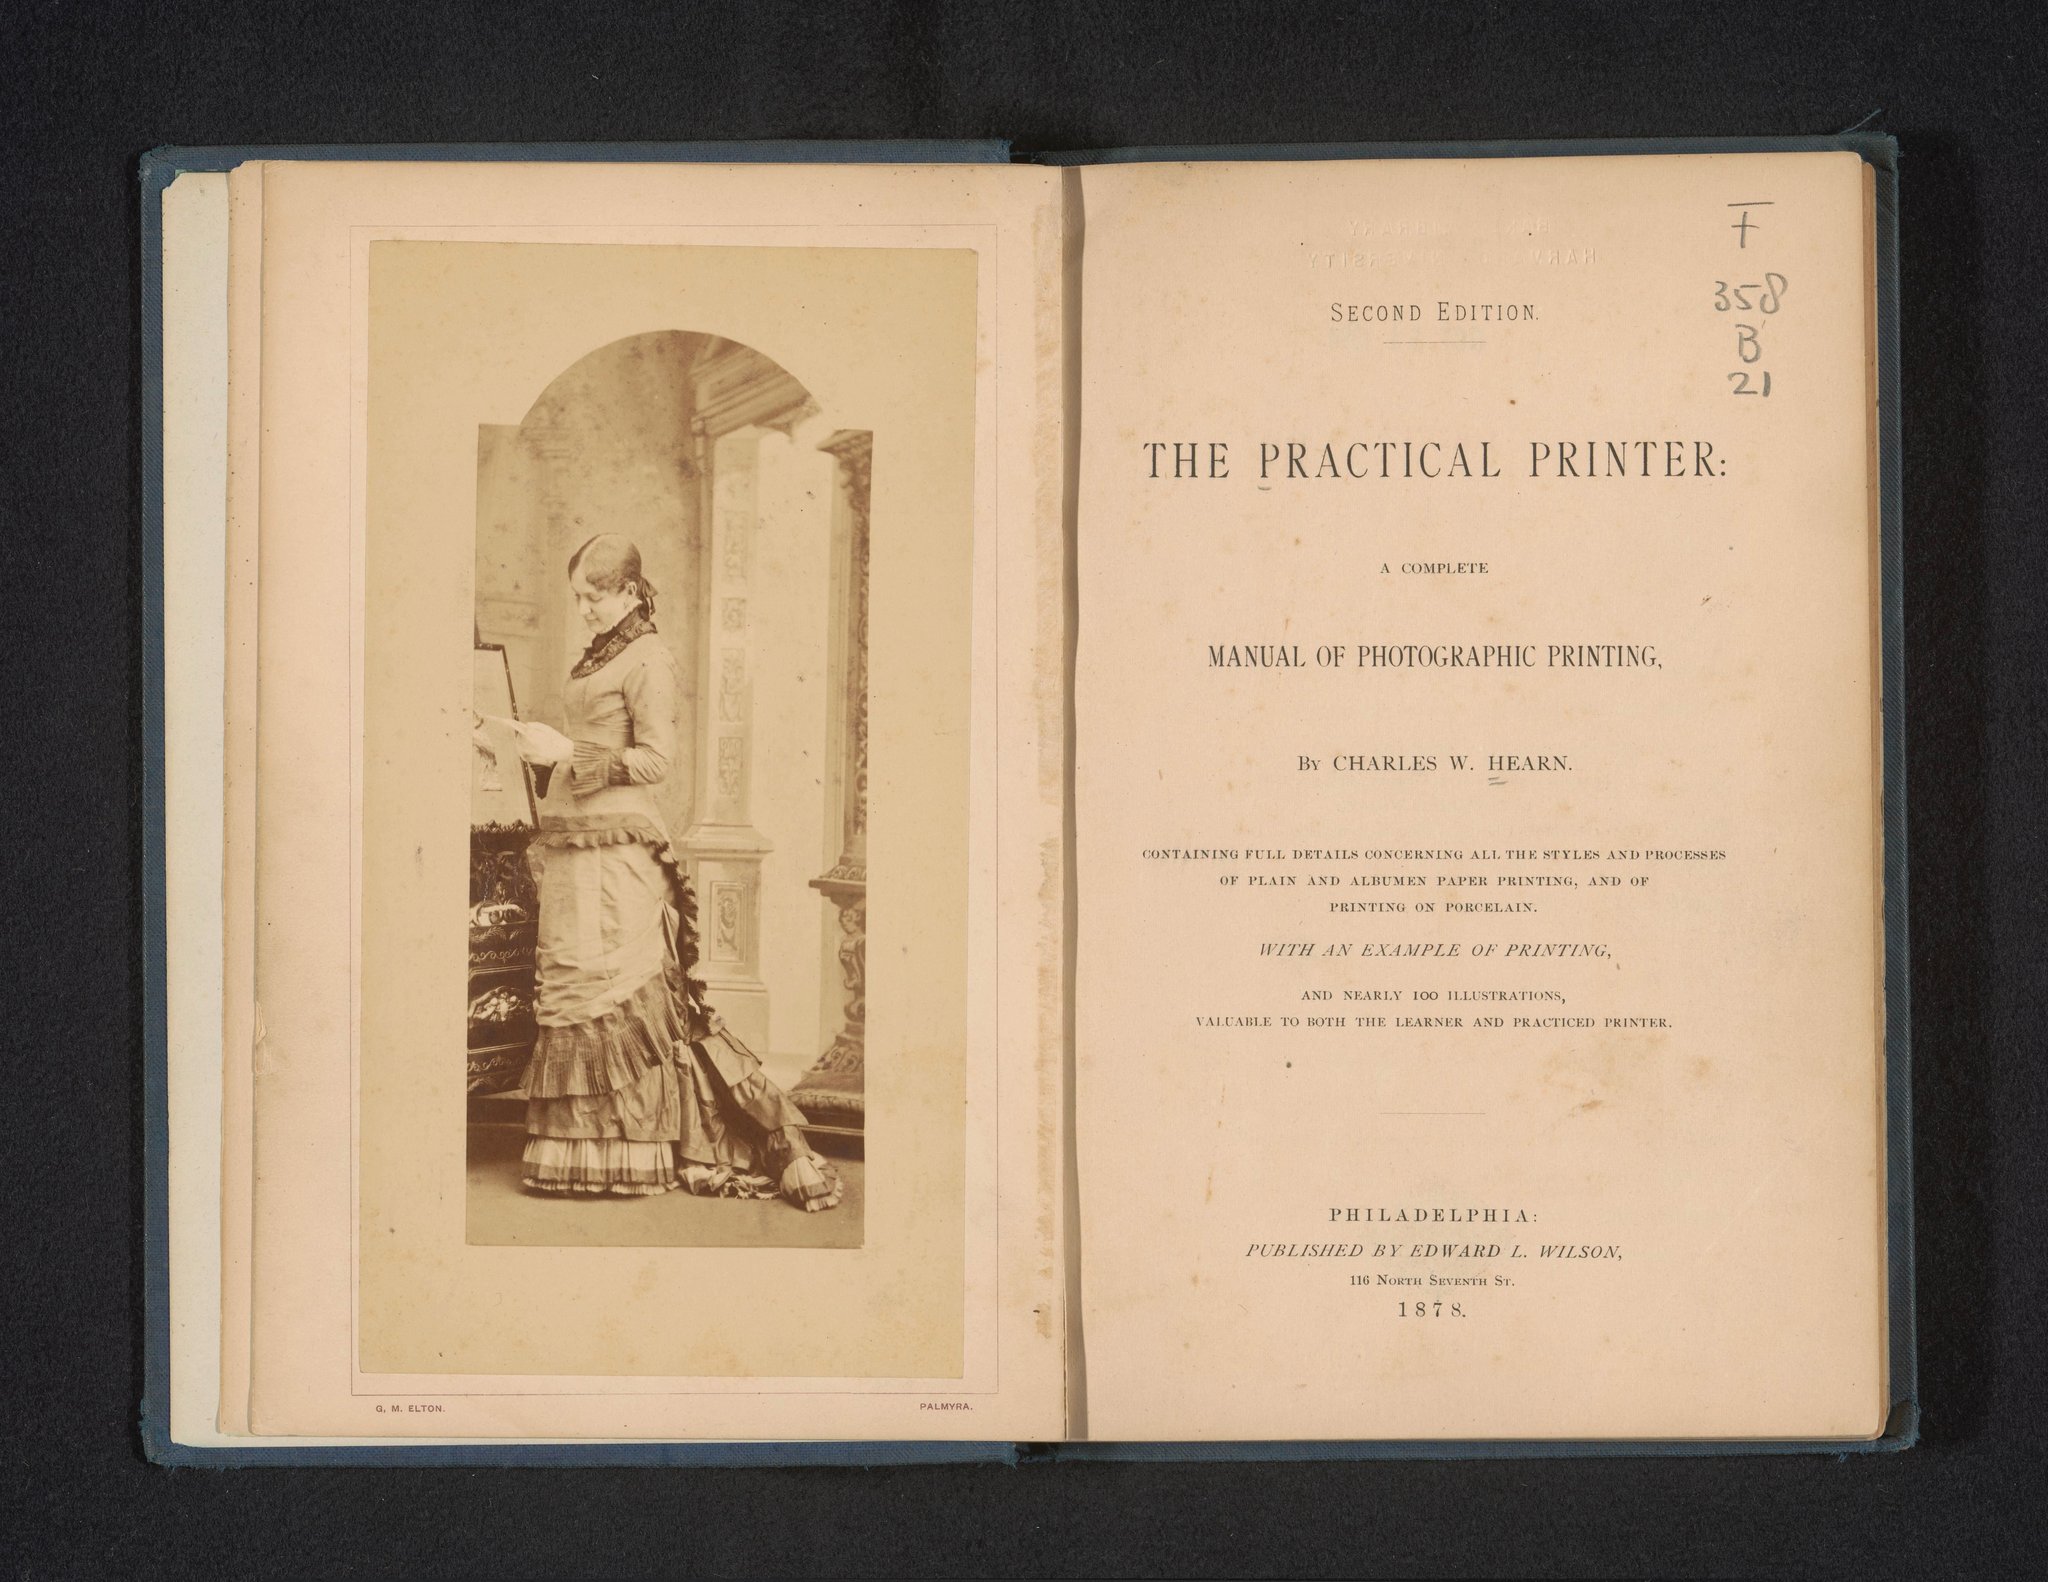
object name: photograph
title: Portret van een onbekende vrouw die een brief leest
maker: george m. elton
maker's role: fotograaf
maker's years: 1848-1927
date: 1873-1878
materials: photographic support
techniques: albumen print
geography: palmyra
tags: historical persons not known by name - bb - woman